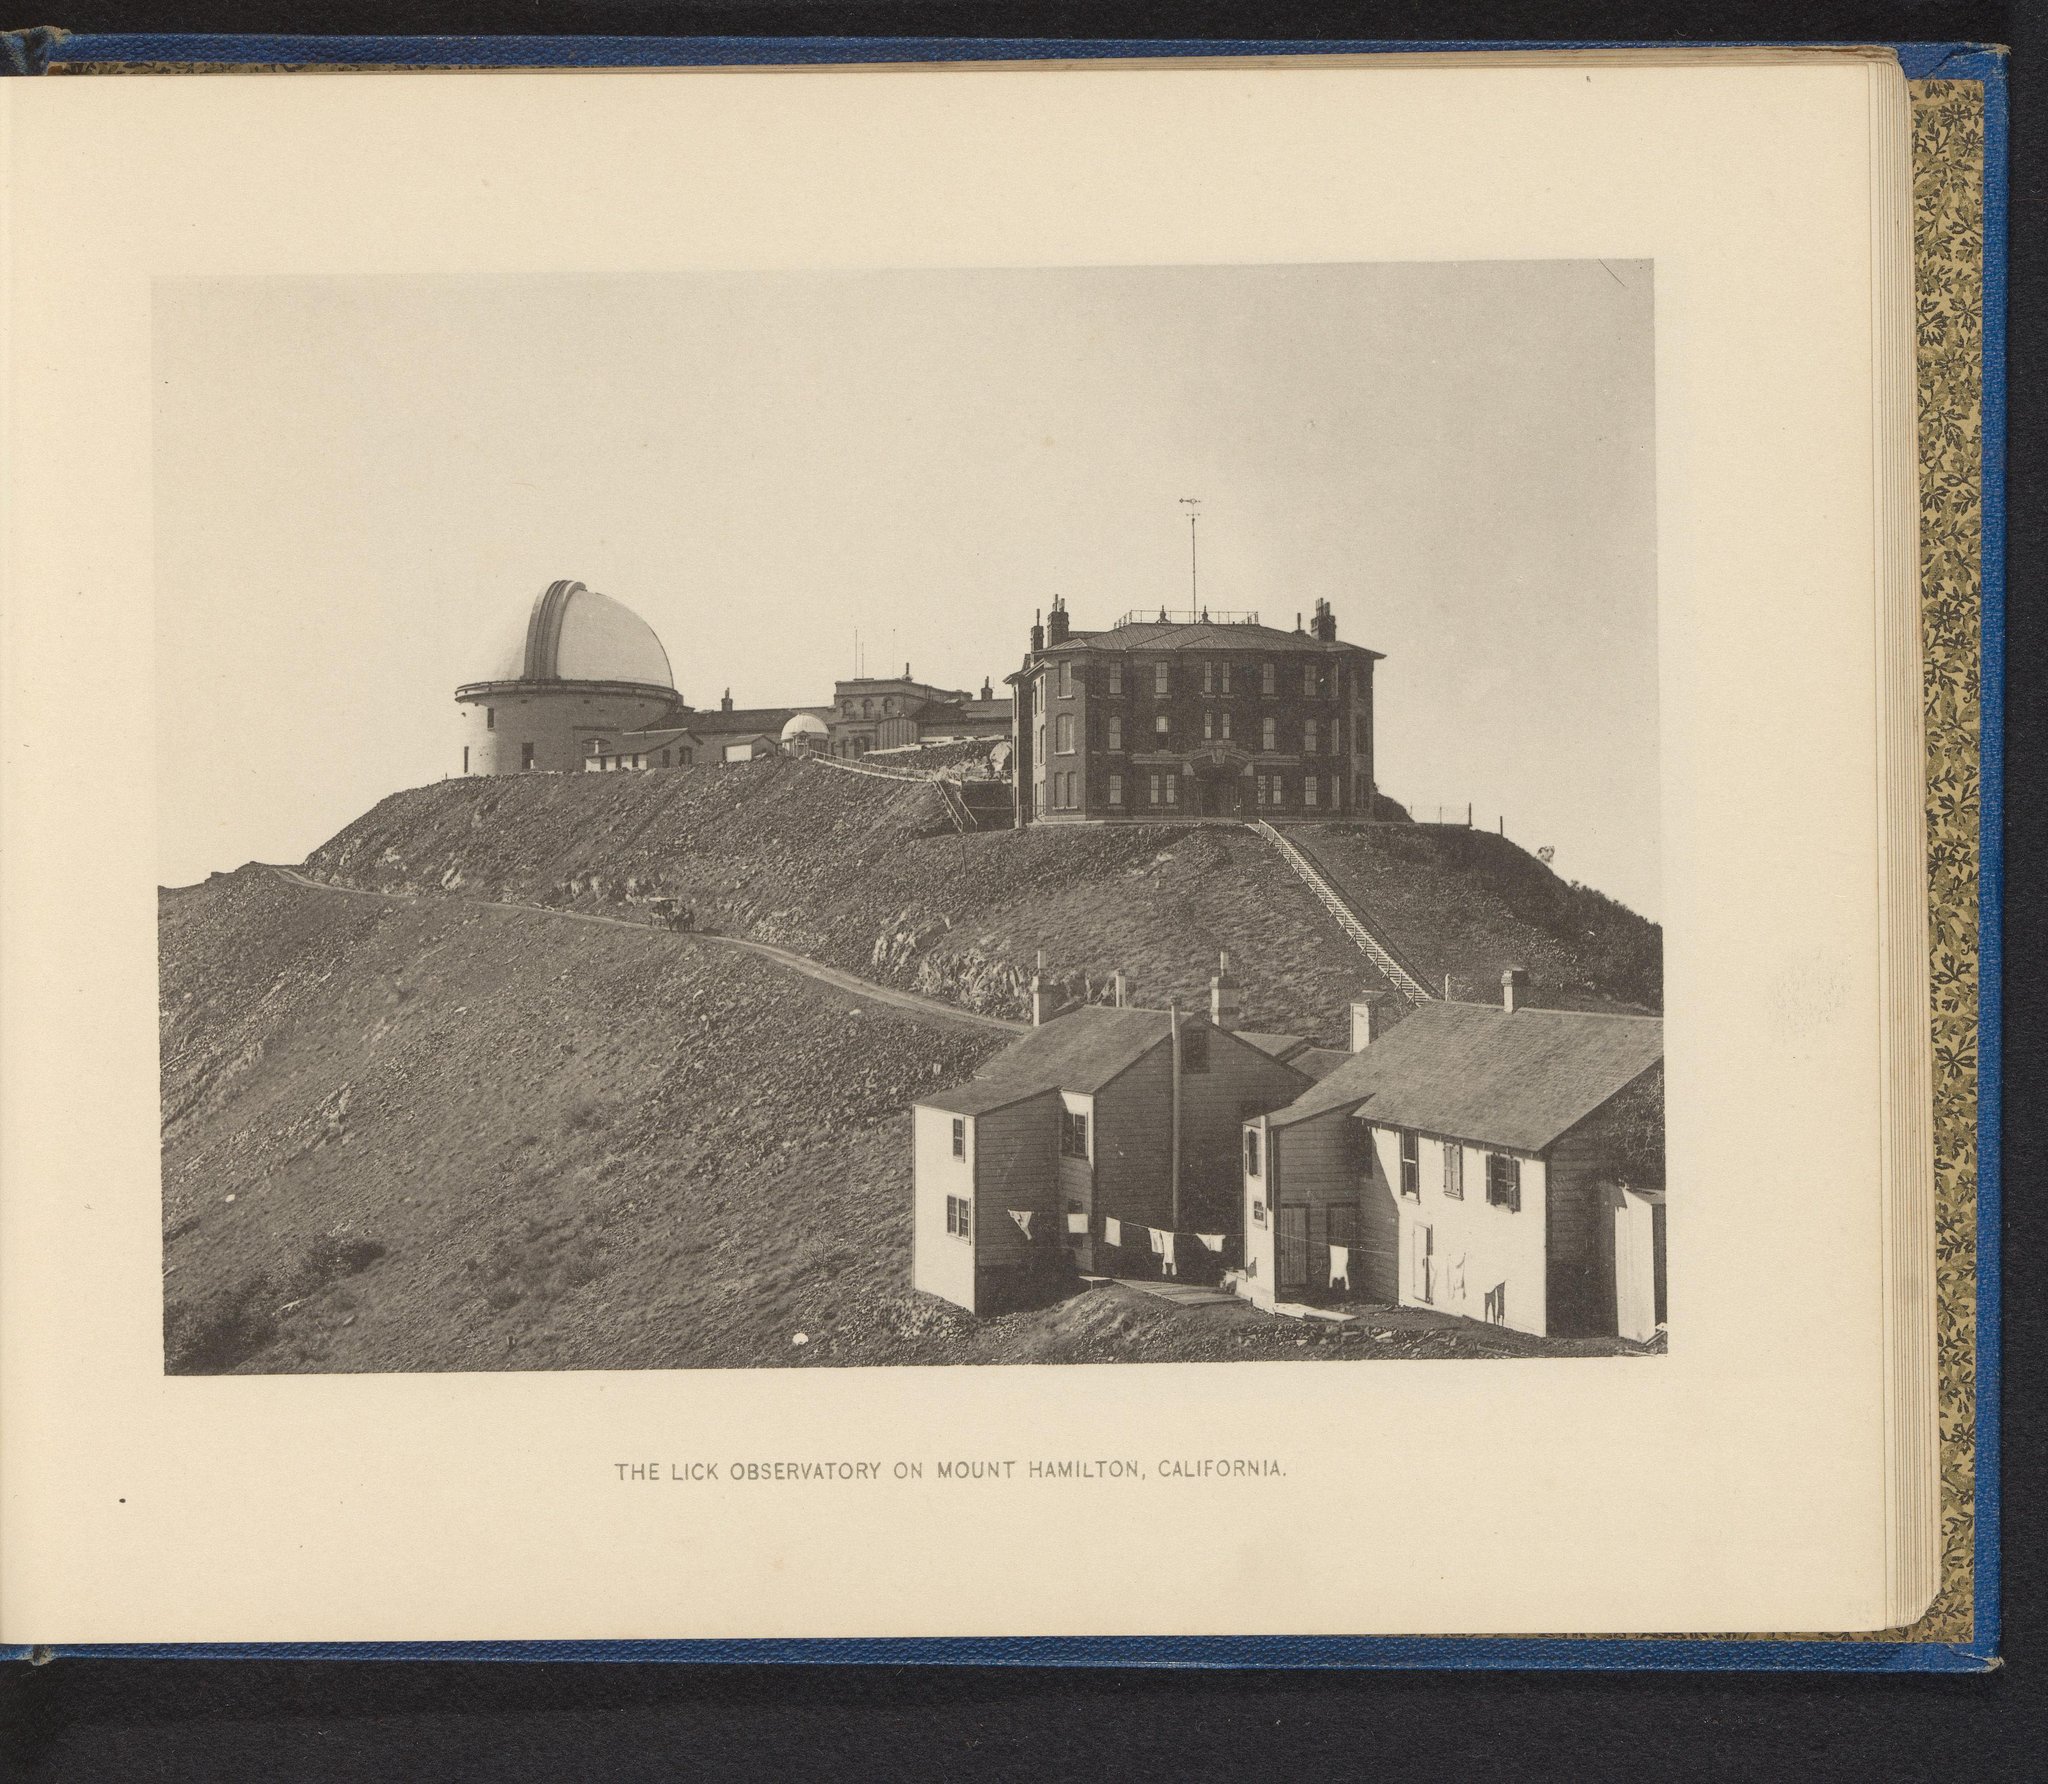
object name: page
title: Gezicht op het Lick-observatorium op Mount Hamilton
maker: Anonymous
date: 1883-1893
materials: paper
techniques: photograph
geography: california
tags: observatory (~ astronomy)